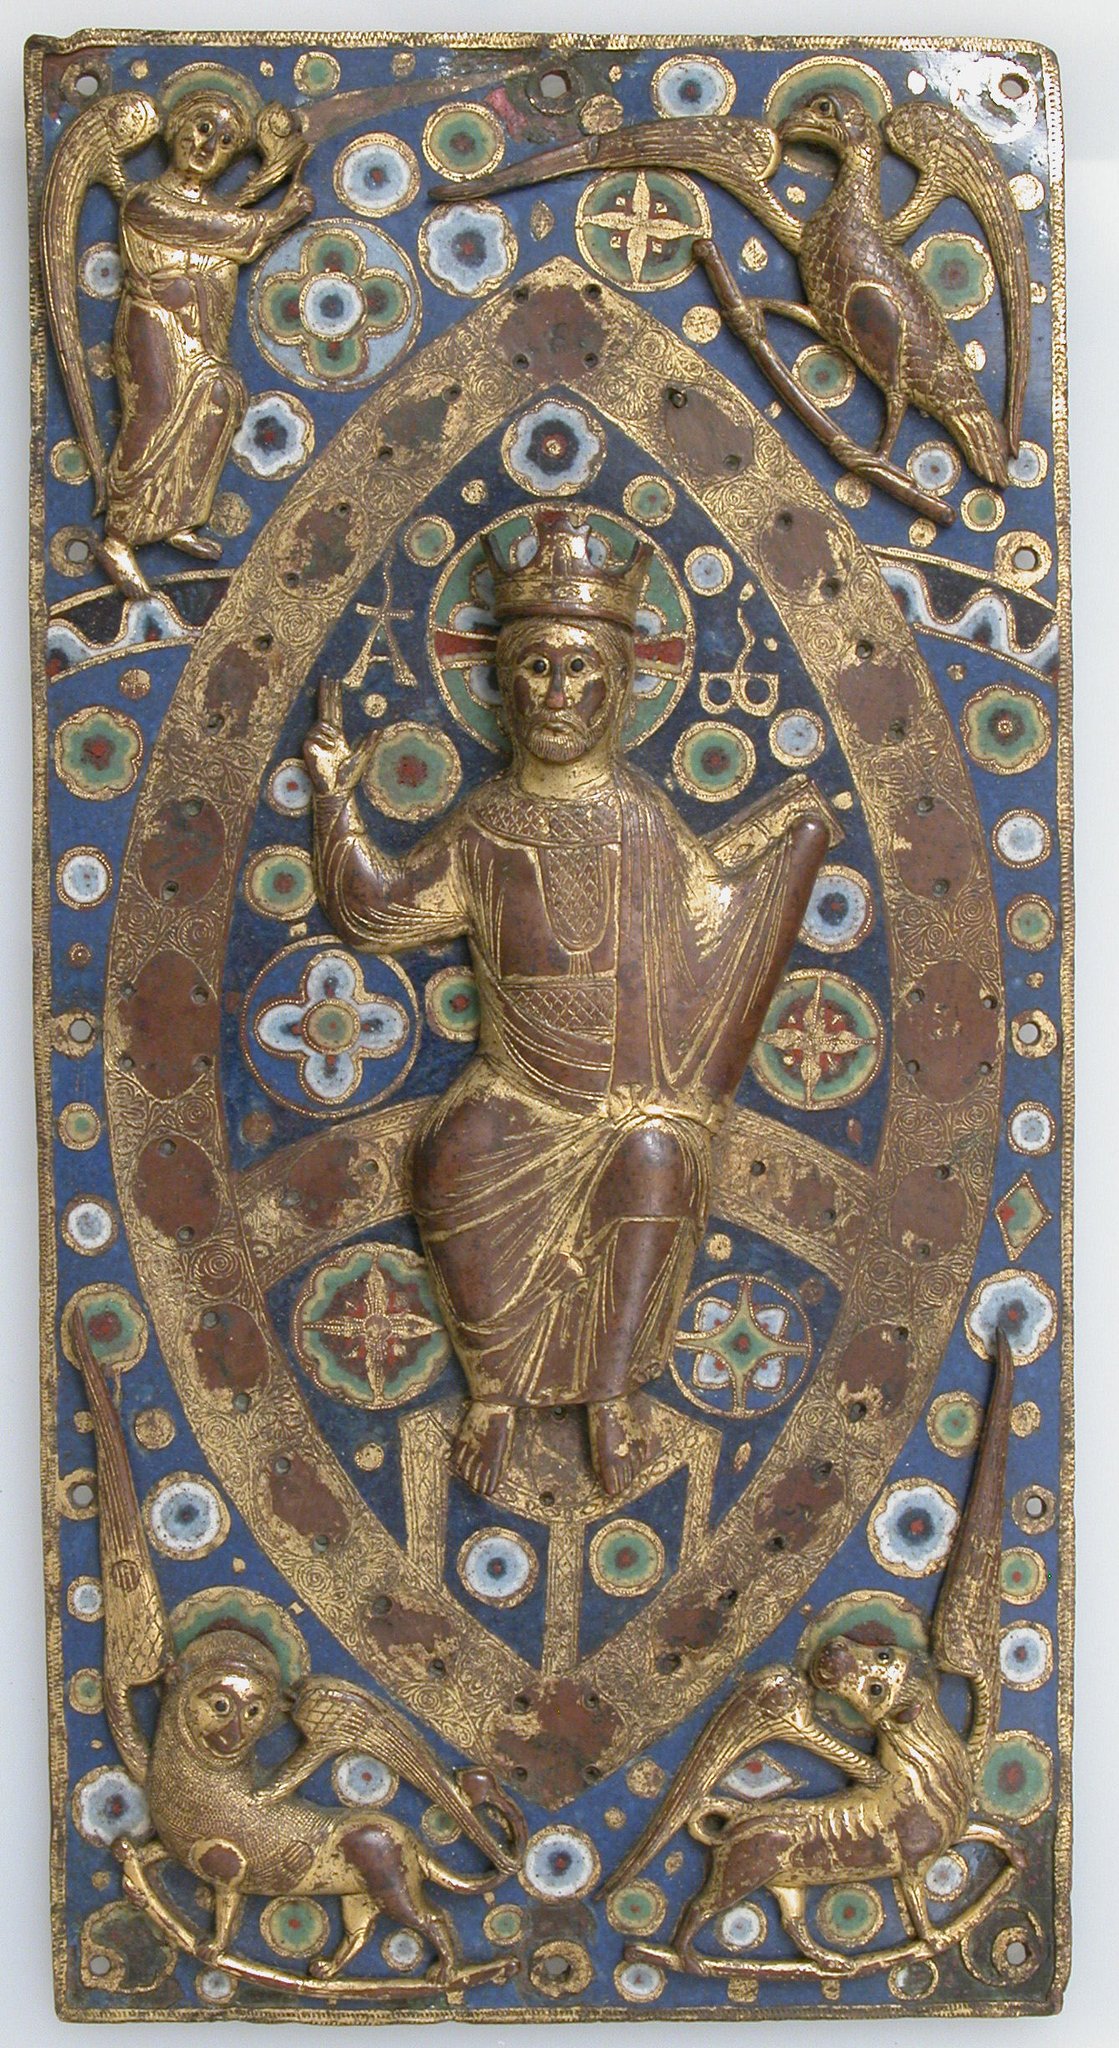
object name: plaque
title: Book Cover Plaque with Christ in Majesty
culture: french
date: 1185-1210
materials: copper, enamel, gilt, glass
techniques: enamel, chasing, engraving, repoussé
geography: france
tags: angels,christ